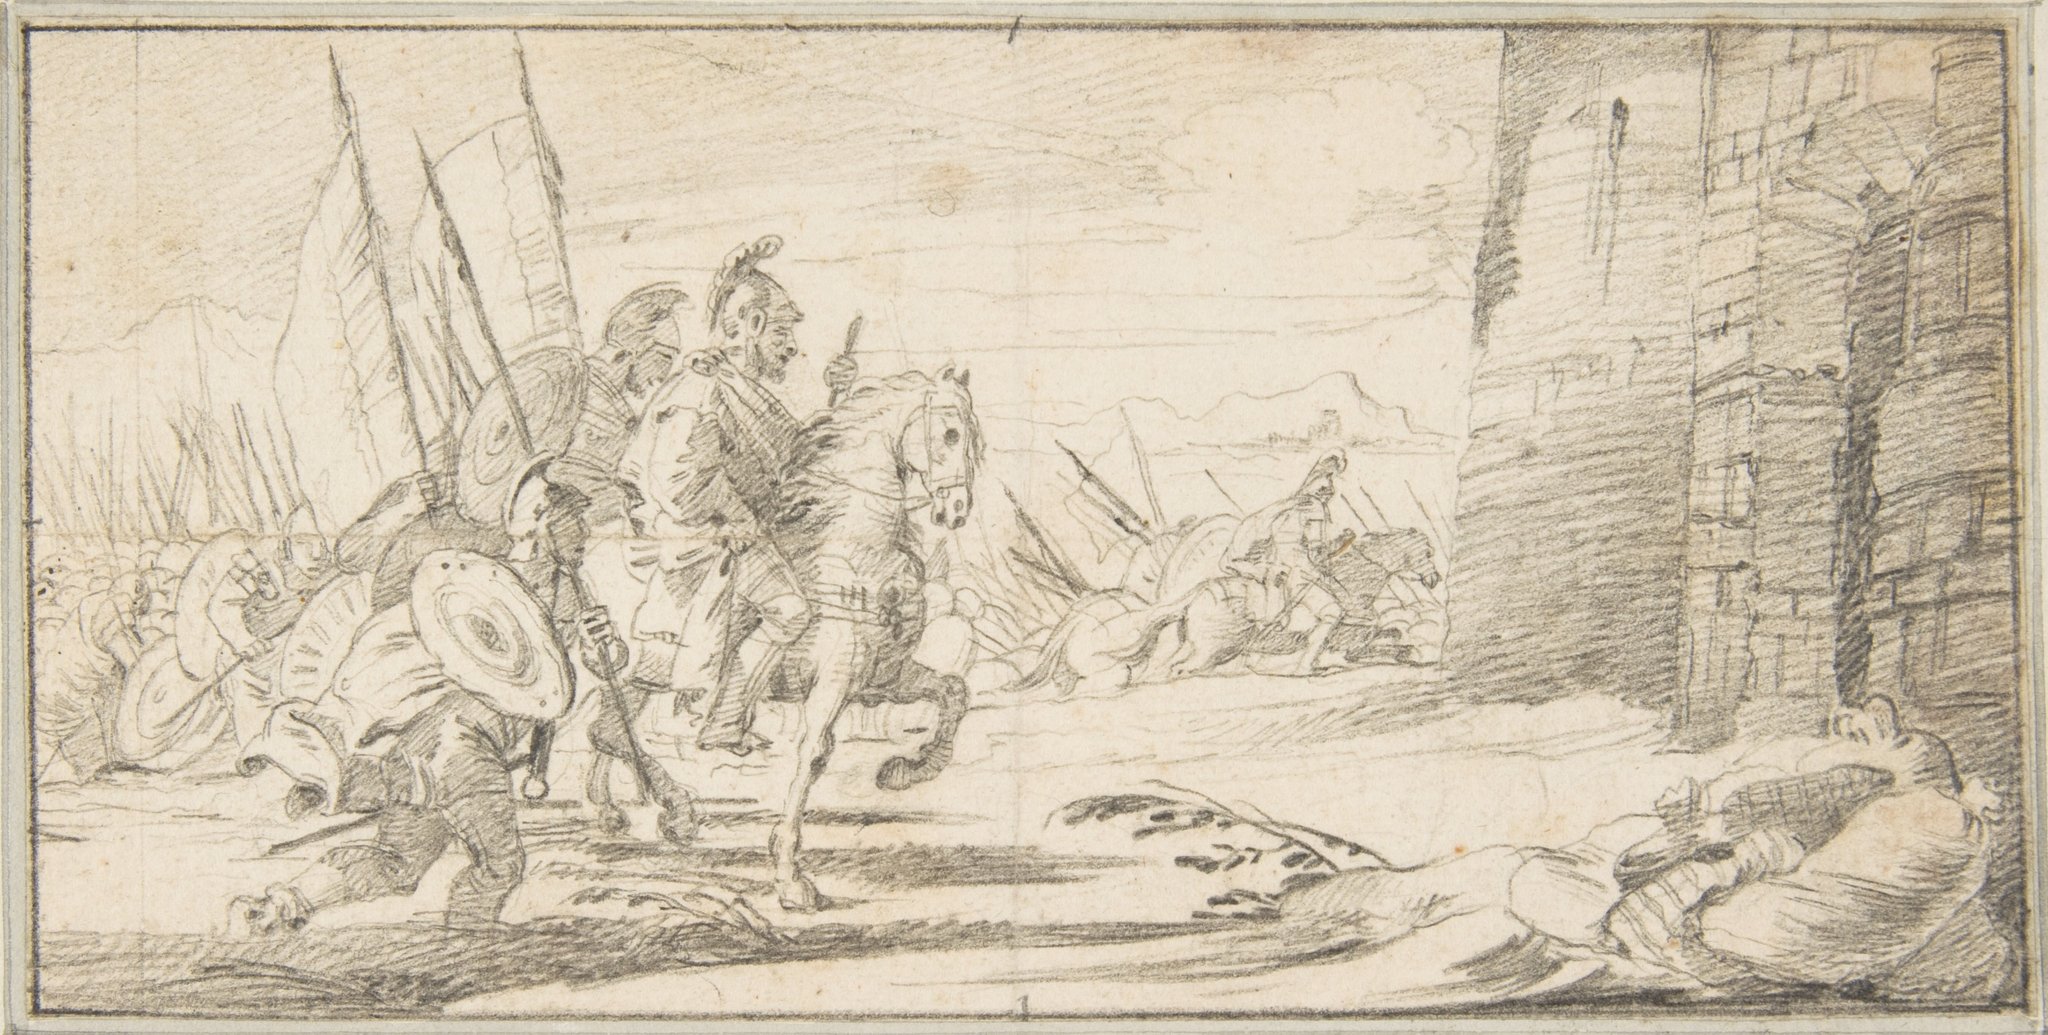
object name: drawing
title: Illustration for a Book: Troops Advancing toward a City Gate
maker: giovanni battista tiepolo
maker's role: artist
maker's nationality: italian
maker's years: 1696-1770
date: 1696-1770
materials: chalk, graphite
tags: gates,soldiers,spears,horses